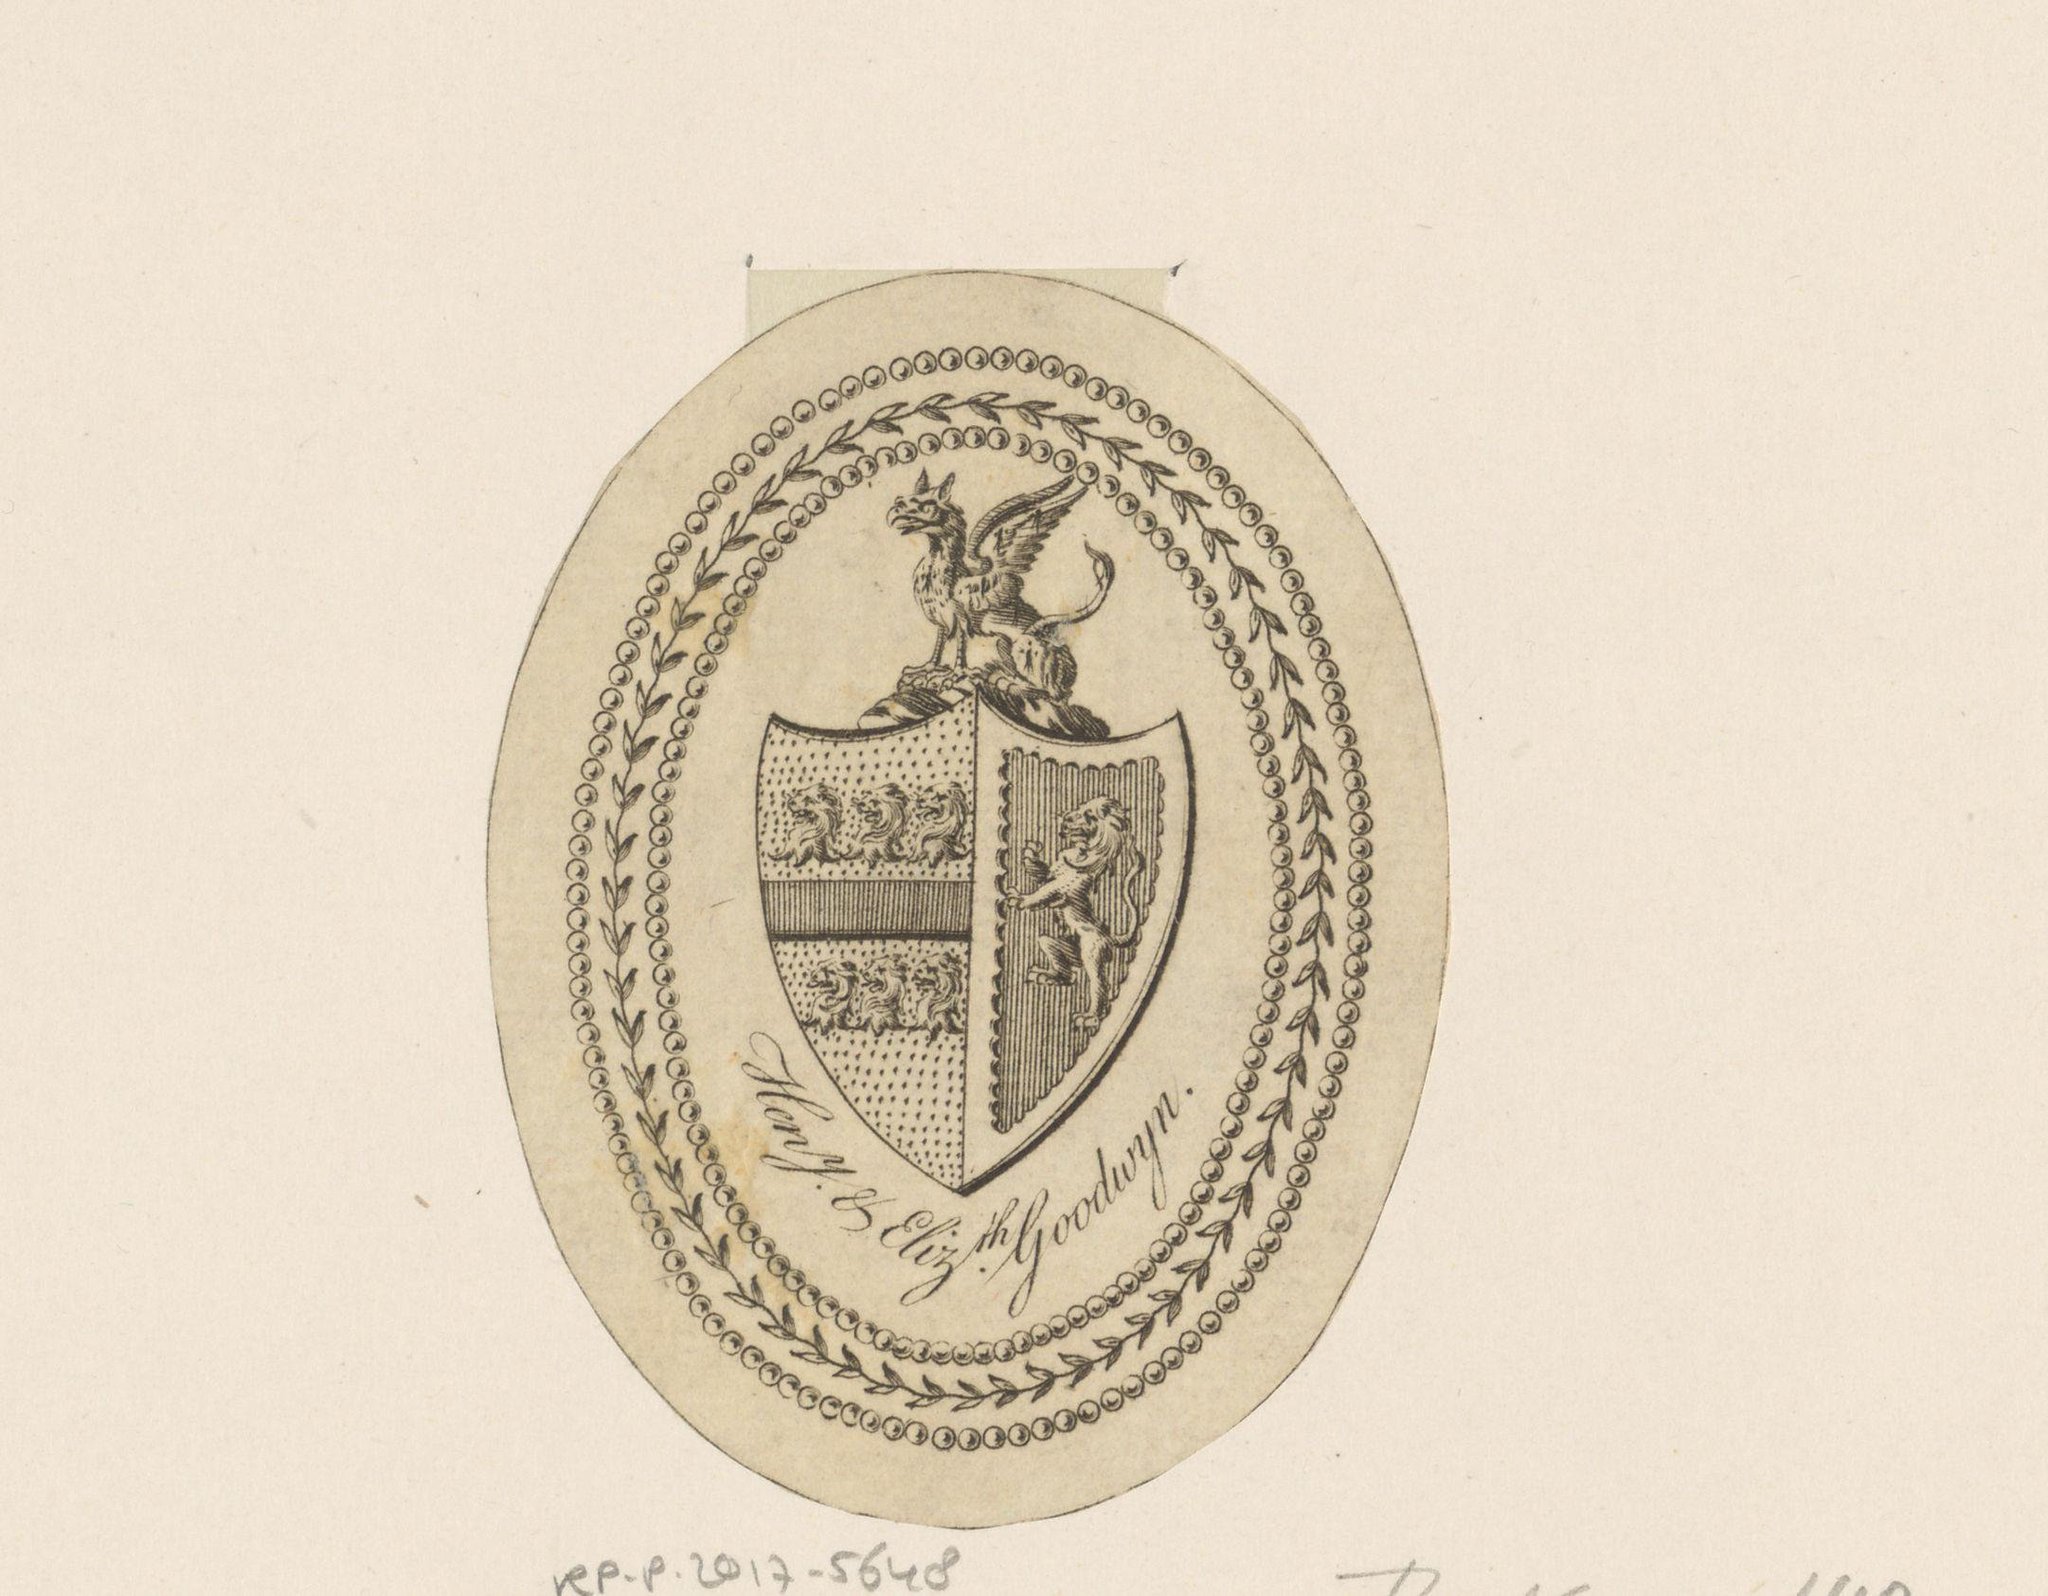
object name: bookplate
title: Ex libris van Henry en Elizabeth Goodwyn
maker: Anonymous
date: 1750-1849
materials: paper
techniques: etching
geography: england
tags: dragon, armorial bearing, heraldry